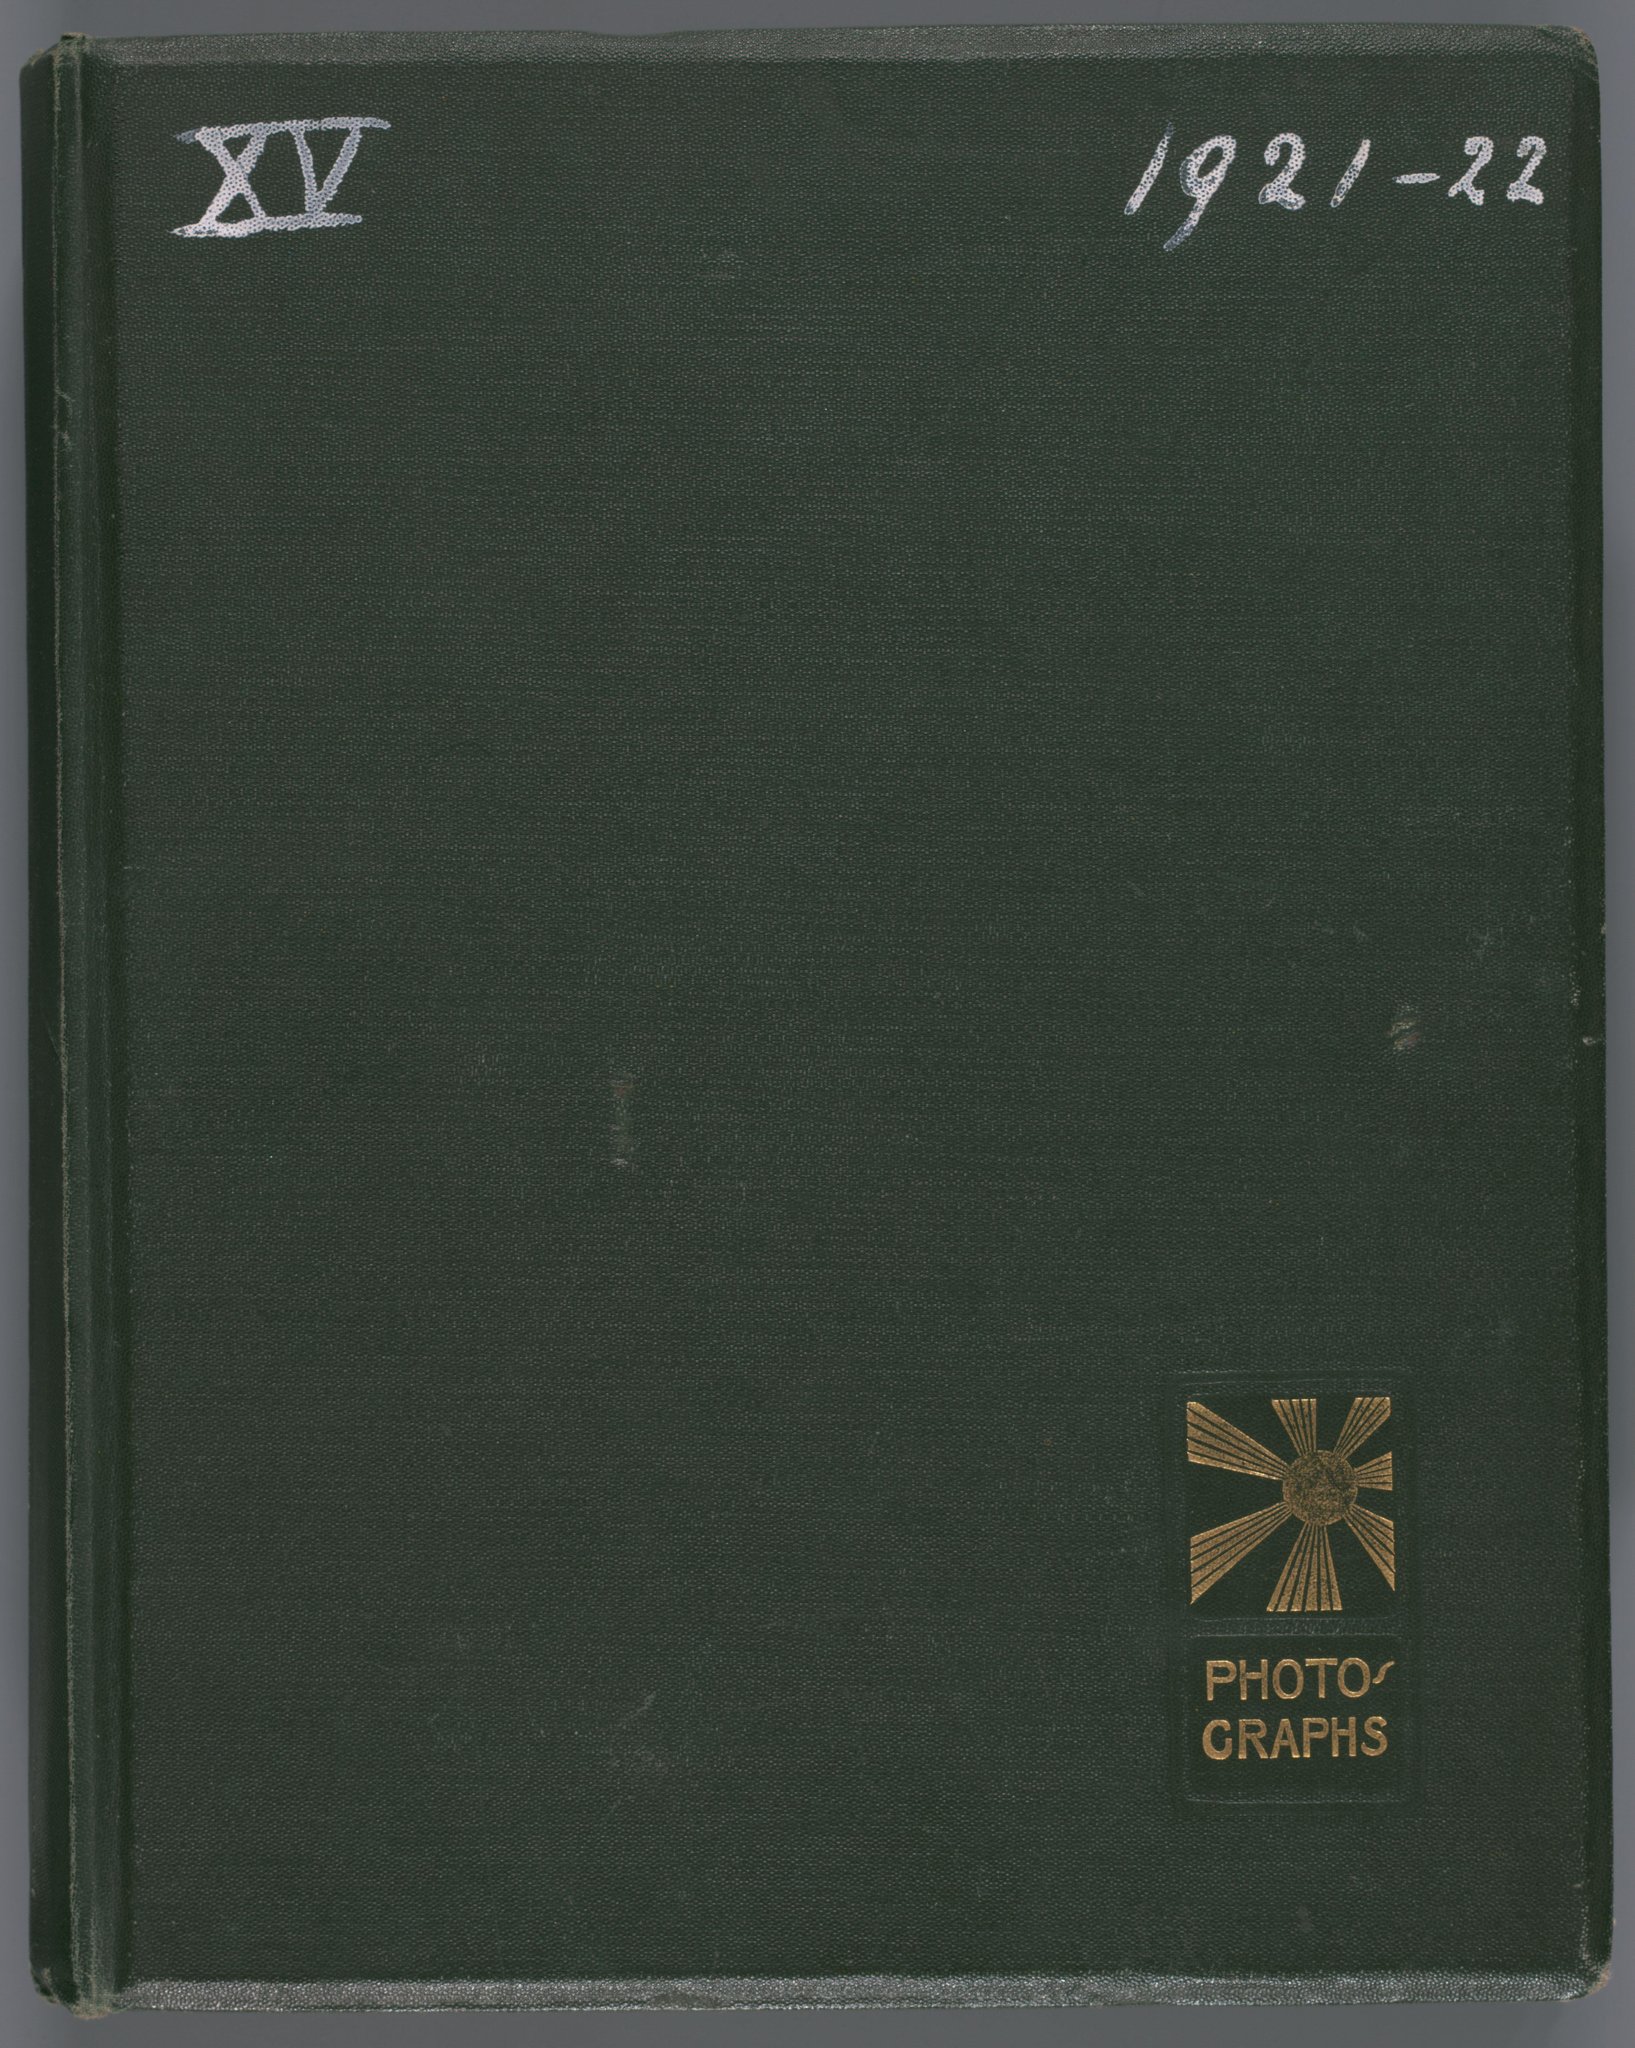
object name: slip in album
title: Photographs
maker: hendrik herman van den berg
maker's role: amateurfotograaf, jurist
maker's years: 1875-1944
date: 1921-1922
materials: paper, cardboard, ink, linen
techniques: gelatin silver print, pen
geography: amsterdam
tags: batavia, amsterdam, hendrik herman van den berg, the hague, caroline louise van den berg-van den berg, walking, hiking (recreation), historical persons, family life, netherlands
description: Insteekalbum met 96 foto's verdeeld over 48 pagina's, voornamelijk van familievakanties en -uitjes binnen Nederland en Baden-Baden, Duitsland. Het album bevat foto's van wandelingen in de buurt van de ruïne van Brederode en verschillende verblijven in Huize Welgelegen in Driebergen. Vrijwel alle foto's bevatten handgeschreven bijschriften.